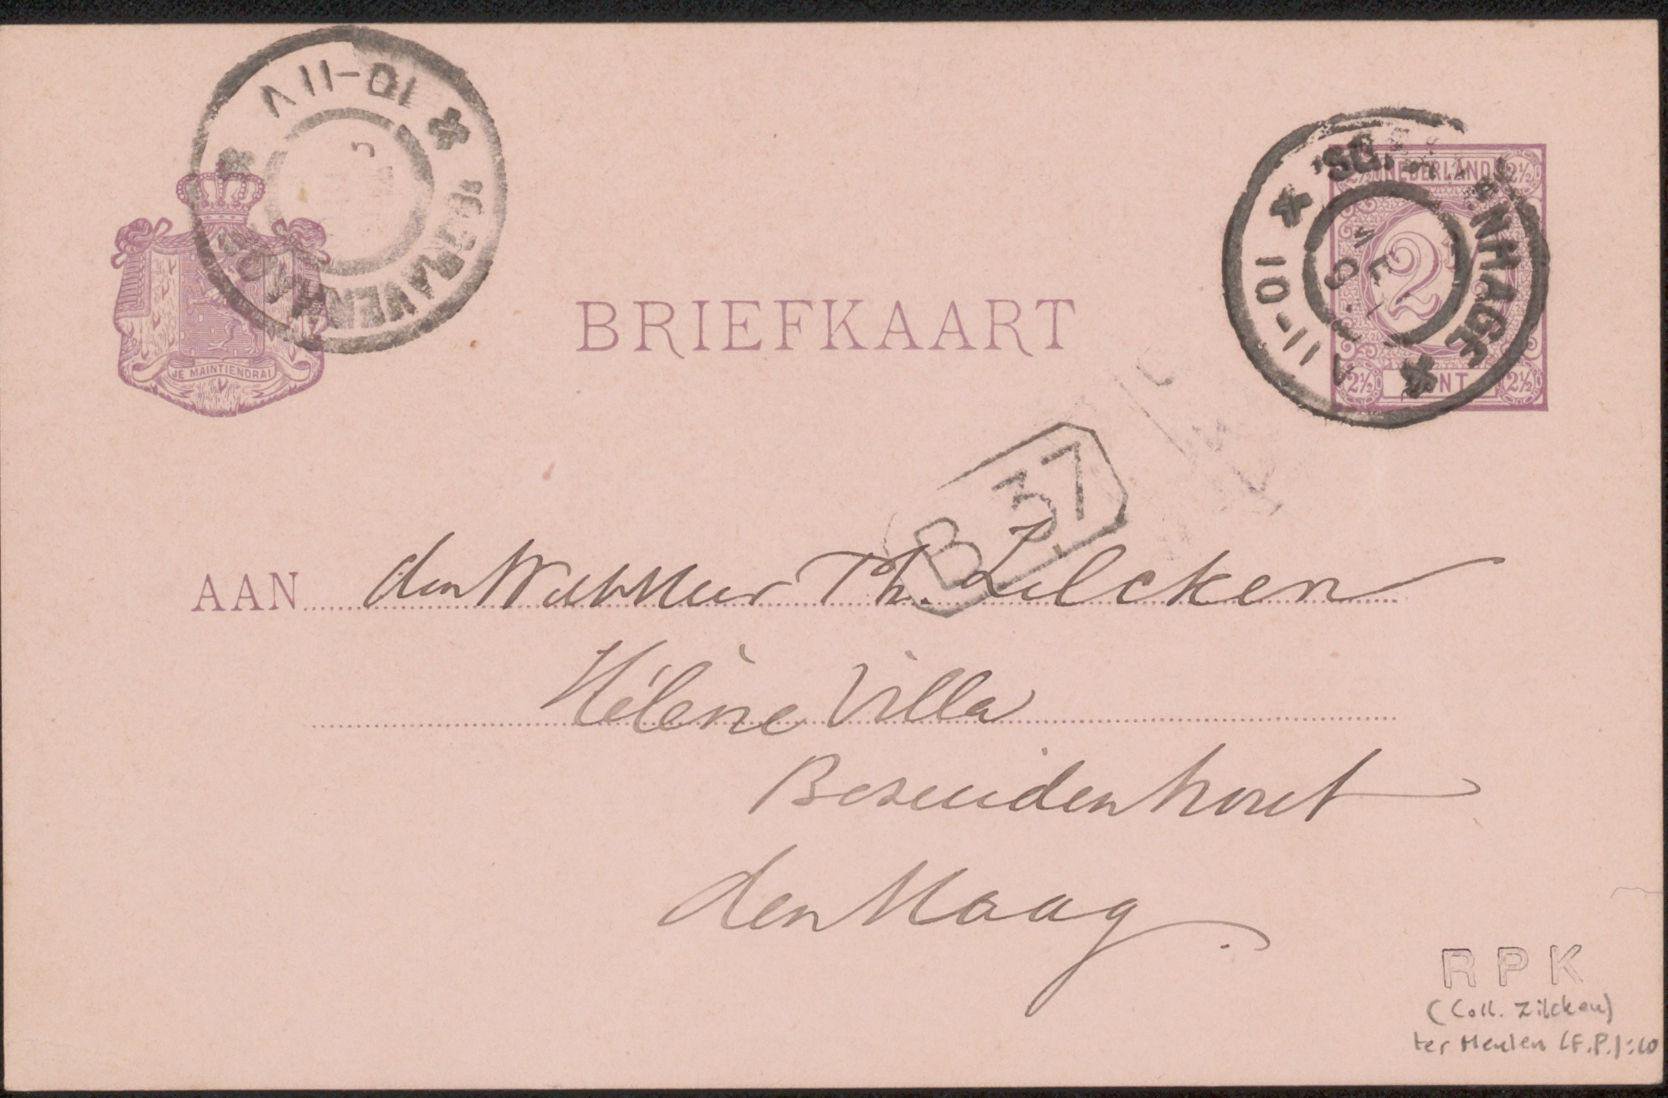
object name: postcard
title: Briefkaart aan Philip Zilcken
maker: françois pieter ter meulen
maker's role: painter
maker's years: 1843-1927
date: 1899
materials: cardboard, ink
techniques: pen, writing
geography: the hague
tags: painter, draughtsman, philip zilcken, photography, cinematography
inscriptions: collector's mark: ‘RPK’